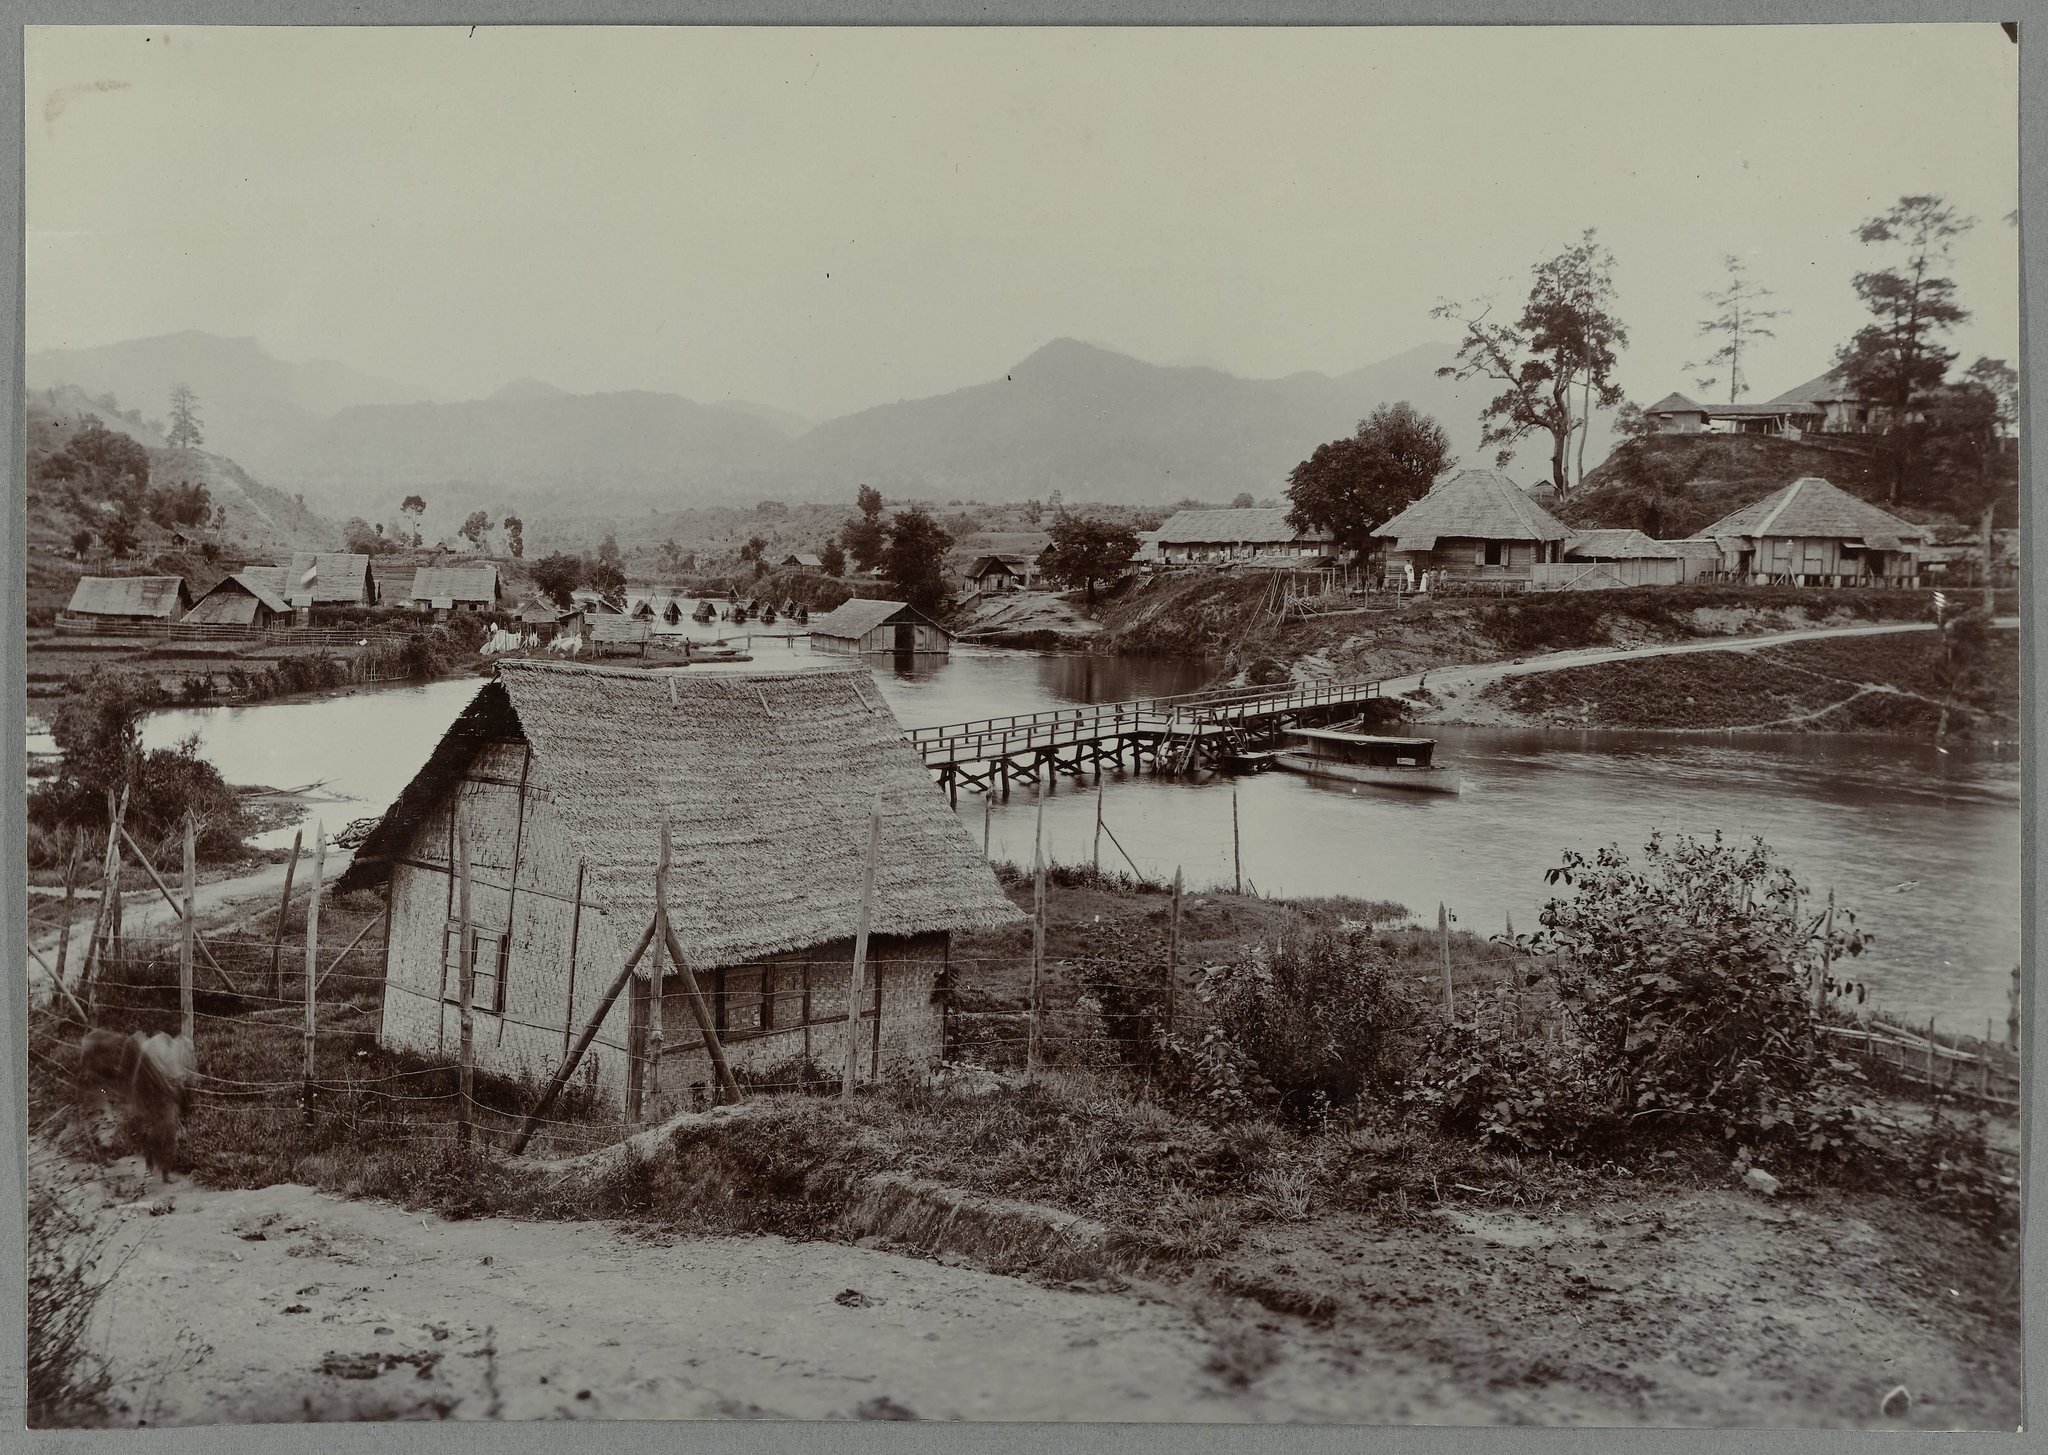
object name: photograph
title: Huizen in Takinguen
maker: Anonymous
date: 1903-1913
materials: photographic support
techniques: photography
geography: north sumatra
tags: albertus dominicus laman trip, landscapes in tropical and sub-tropical regions, village, lake, road, path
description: Na de expedities naar de Gajo- en Alaslanden o.l.v. Van Daalen (eerste tocht in 1901), werd hij in 1903 belast met voorbereiding van permanente vestiging van Nederlands gezag. Aanleg van een weg van de Noordkust naar het binnenland was hierbij van groot belang. Deze zgn. Gajoweg werd aangelegd tussen 1903 en 1914, van Bireuen aan de kust naar Takinguen aan het bergmeer Danau Lauttawar, totale lente 104 km.